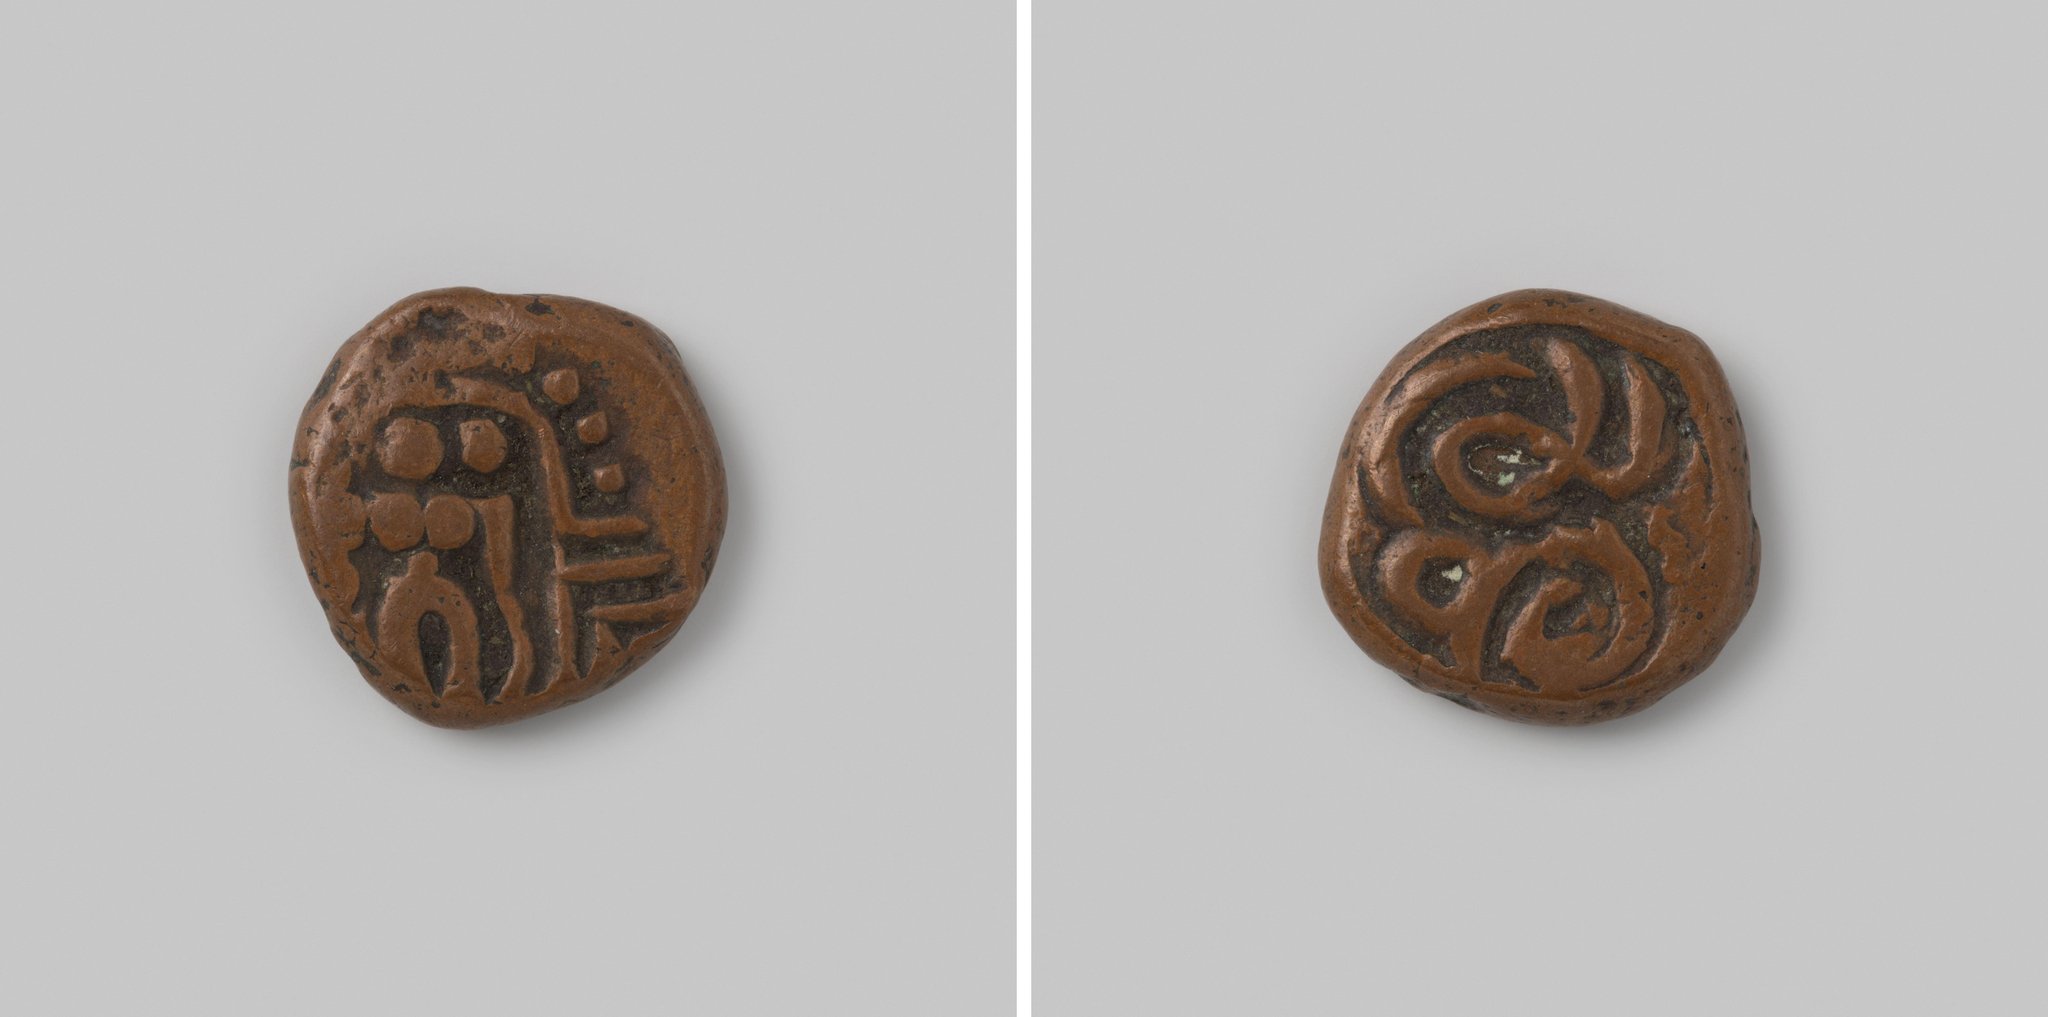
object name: coin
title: 2 kasu uit Tinnevelli in India onder de Nayakas,1700-1800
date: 1700-1800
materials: copper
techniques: striking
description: Koperen munt. Voorzijde: onder toegangspoort Venkatesvara staande van voren. Keerzijde: in Telingisch schrift in twee regels de naam: Sri vira.